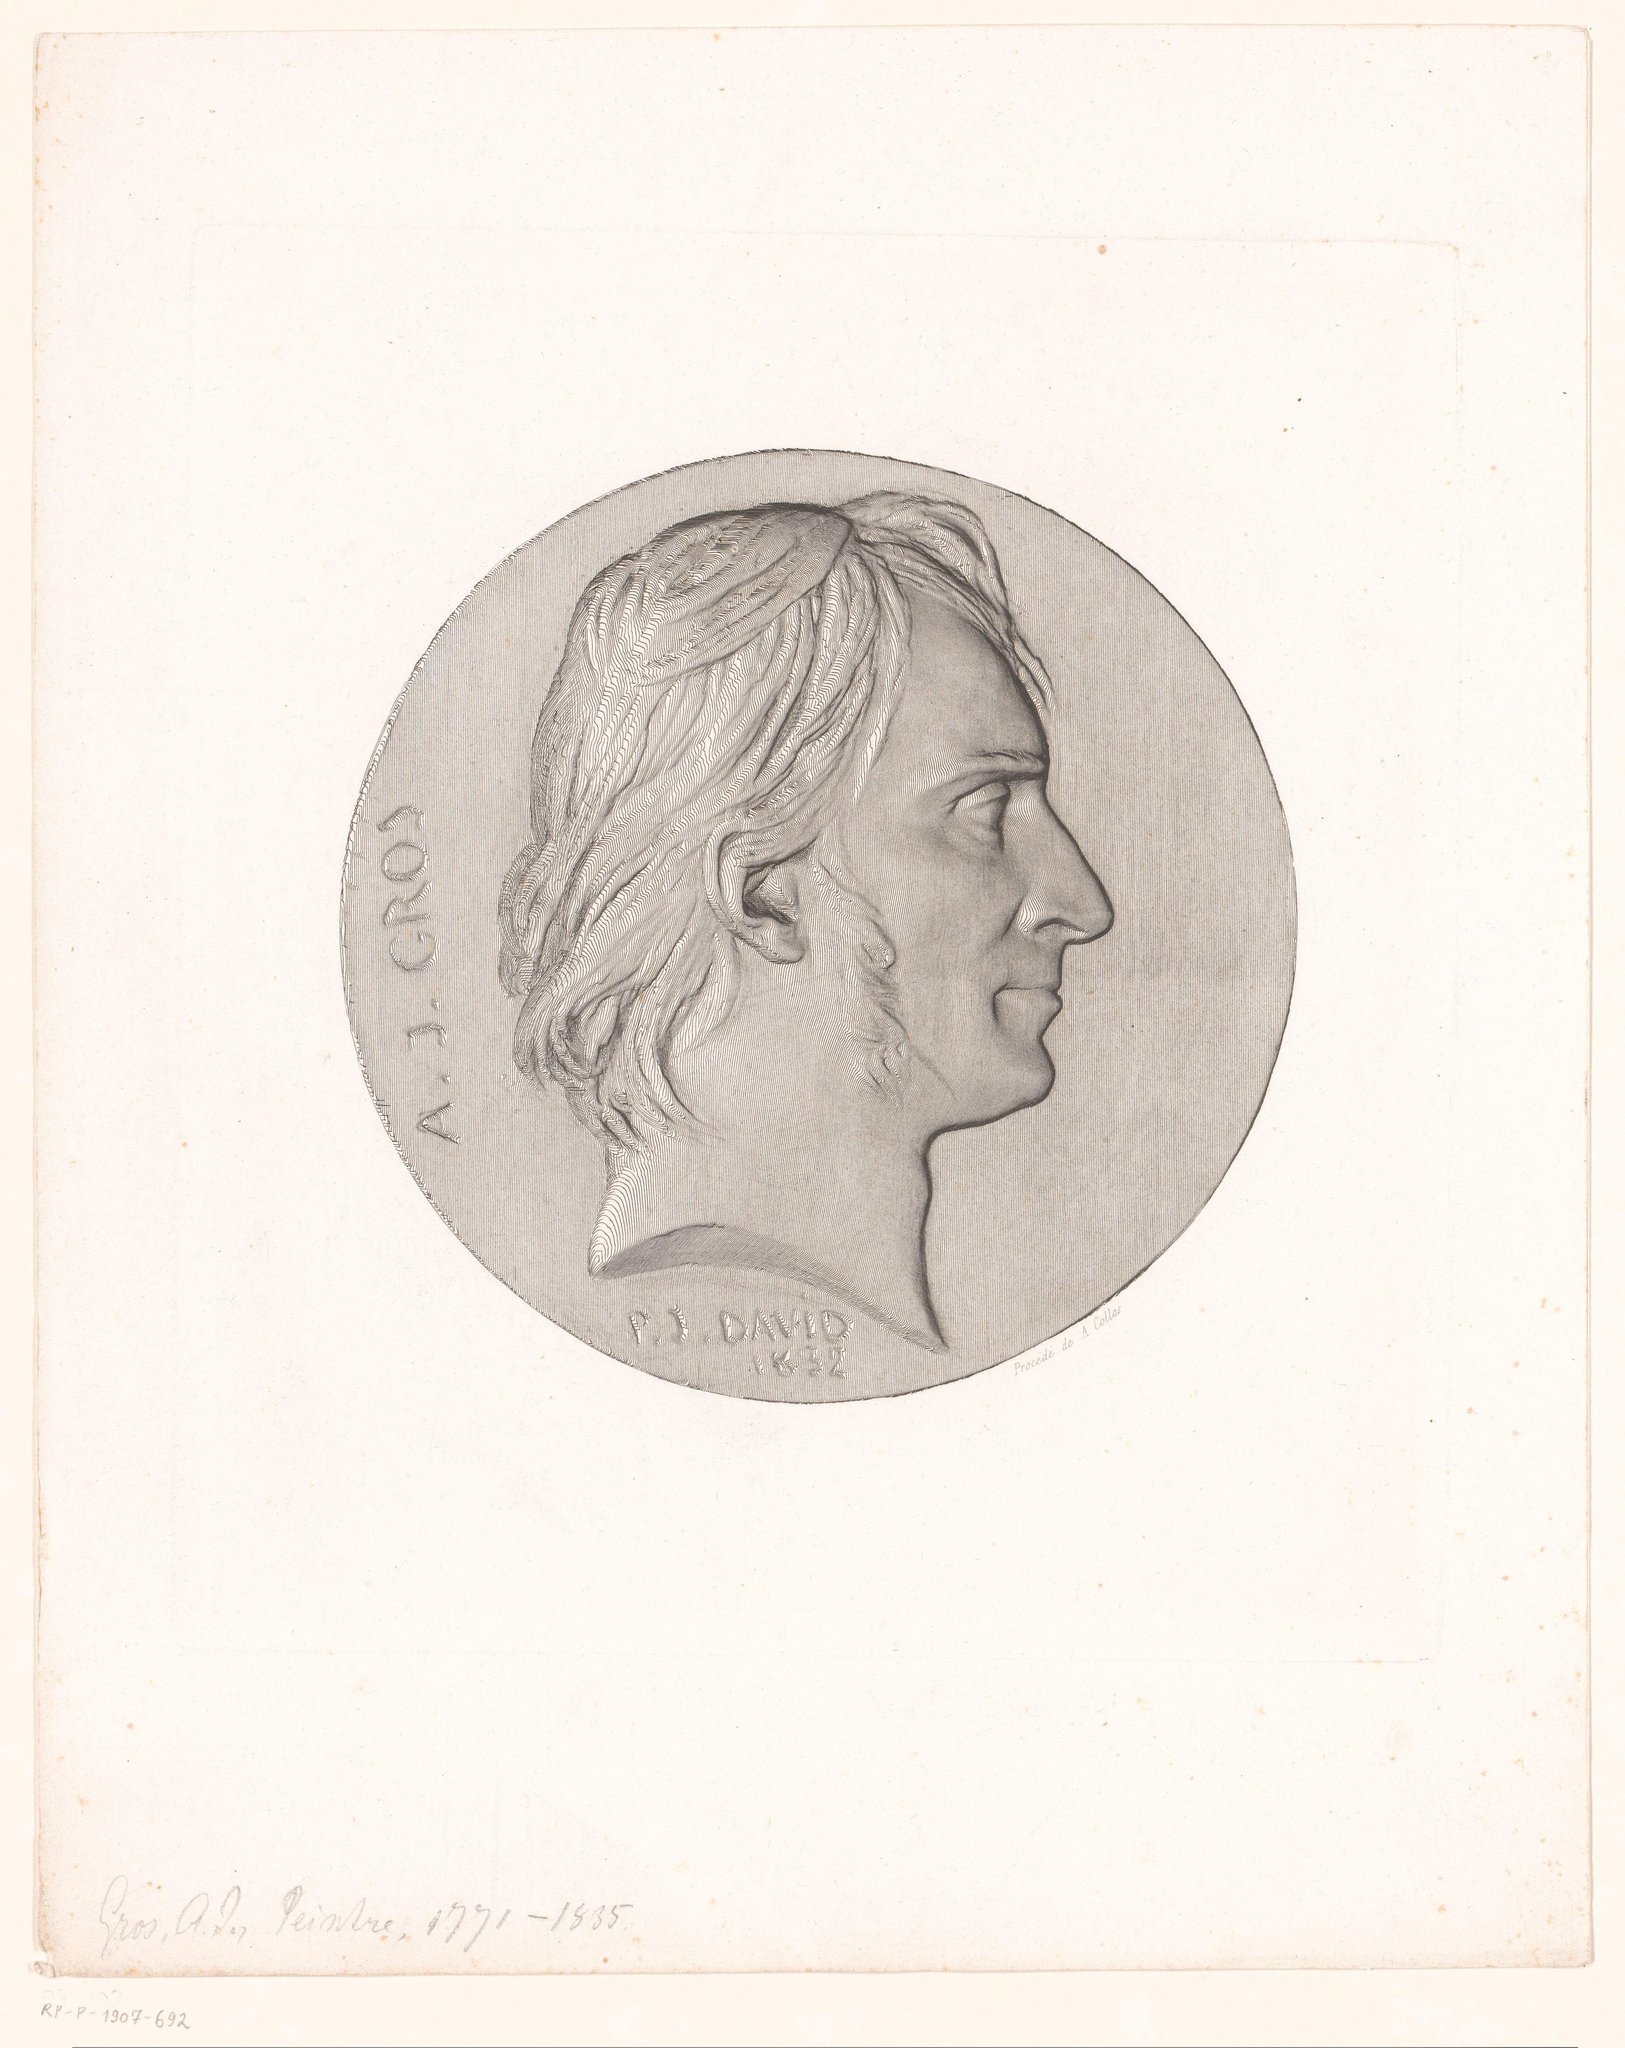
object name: print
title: A.J. Gros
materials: paper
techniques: relief engraving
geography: france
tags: paris, antoine-jean gros, ornament ~ medallion, historical persons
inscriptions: collector's mark: Lugt 2228